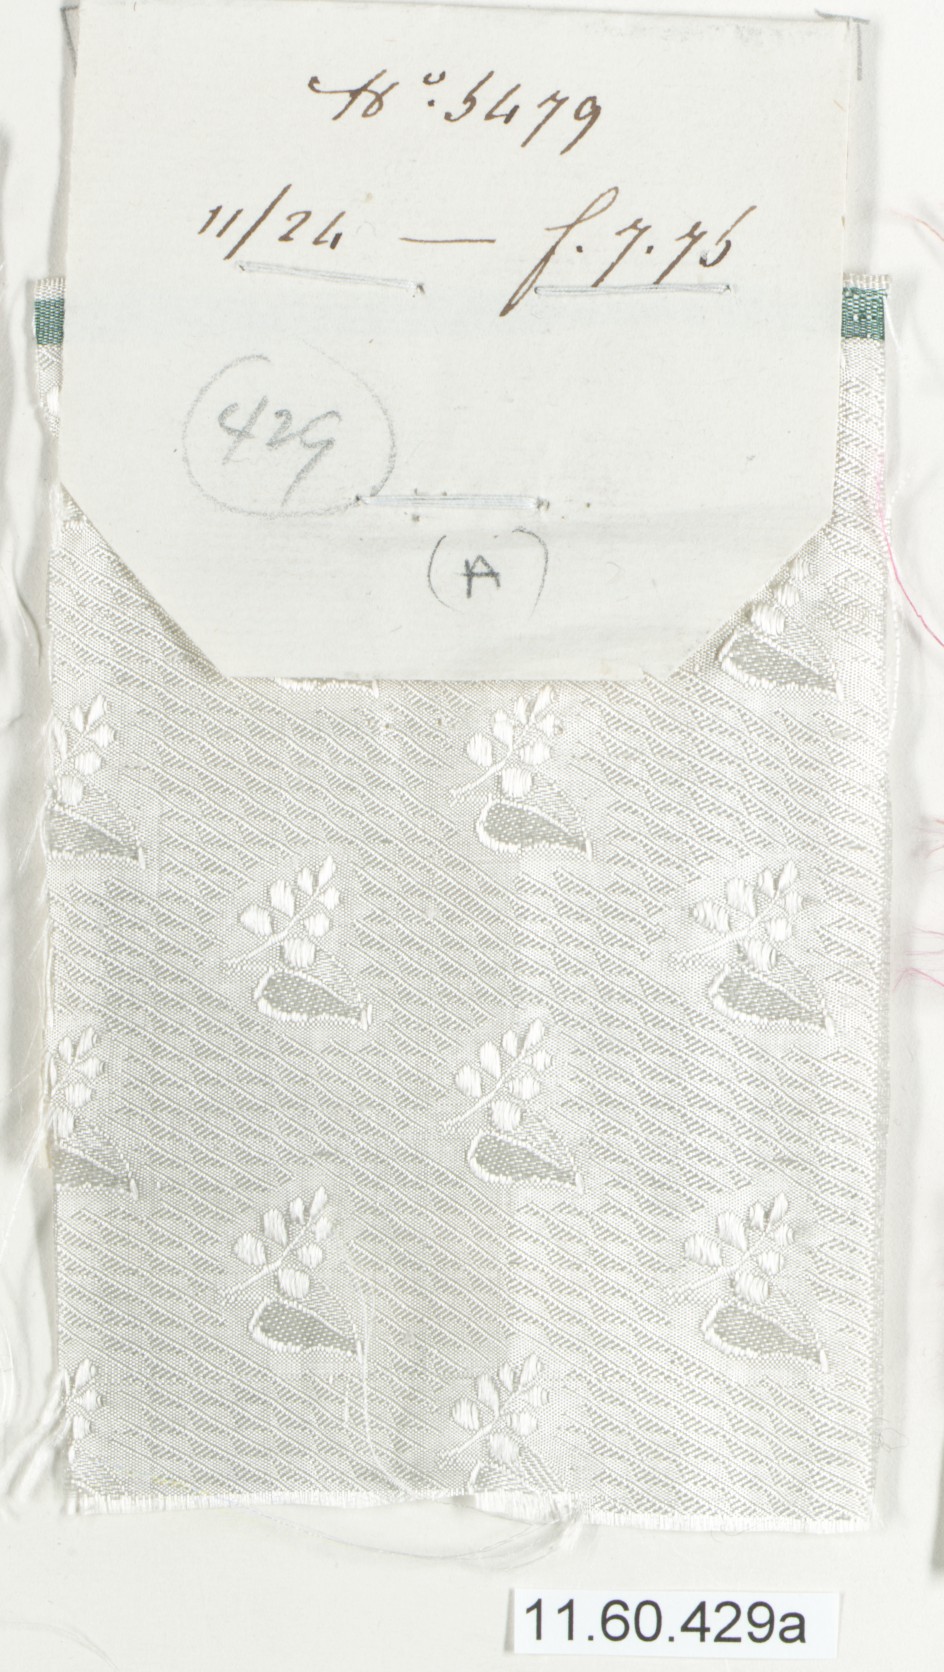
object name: fragment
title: Fragments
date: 1801-1900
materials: silk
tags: leaves